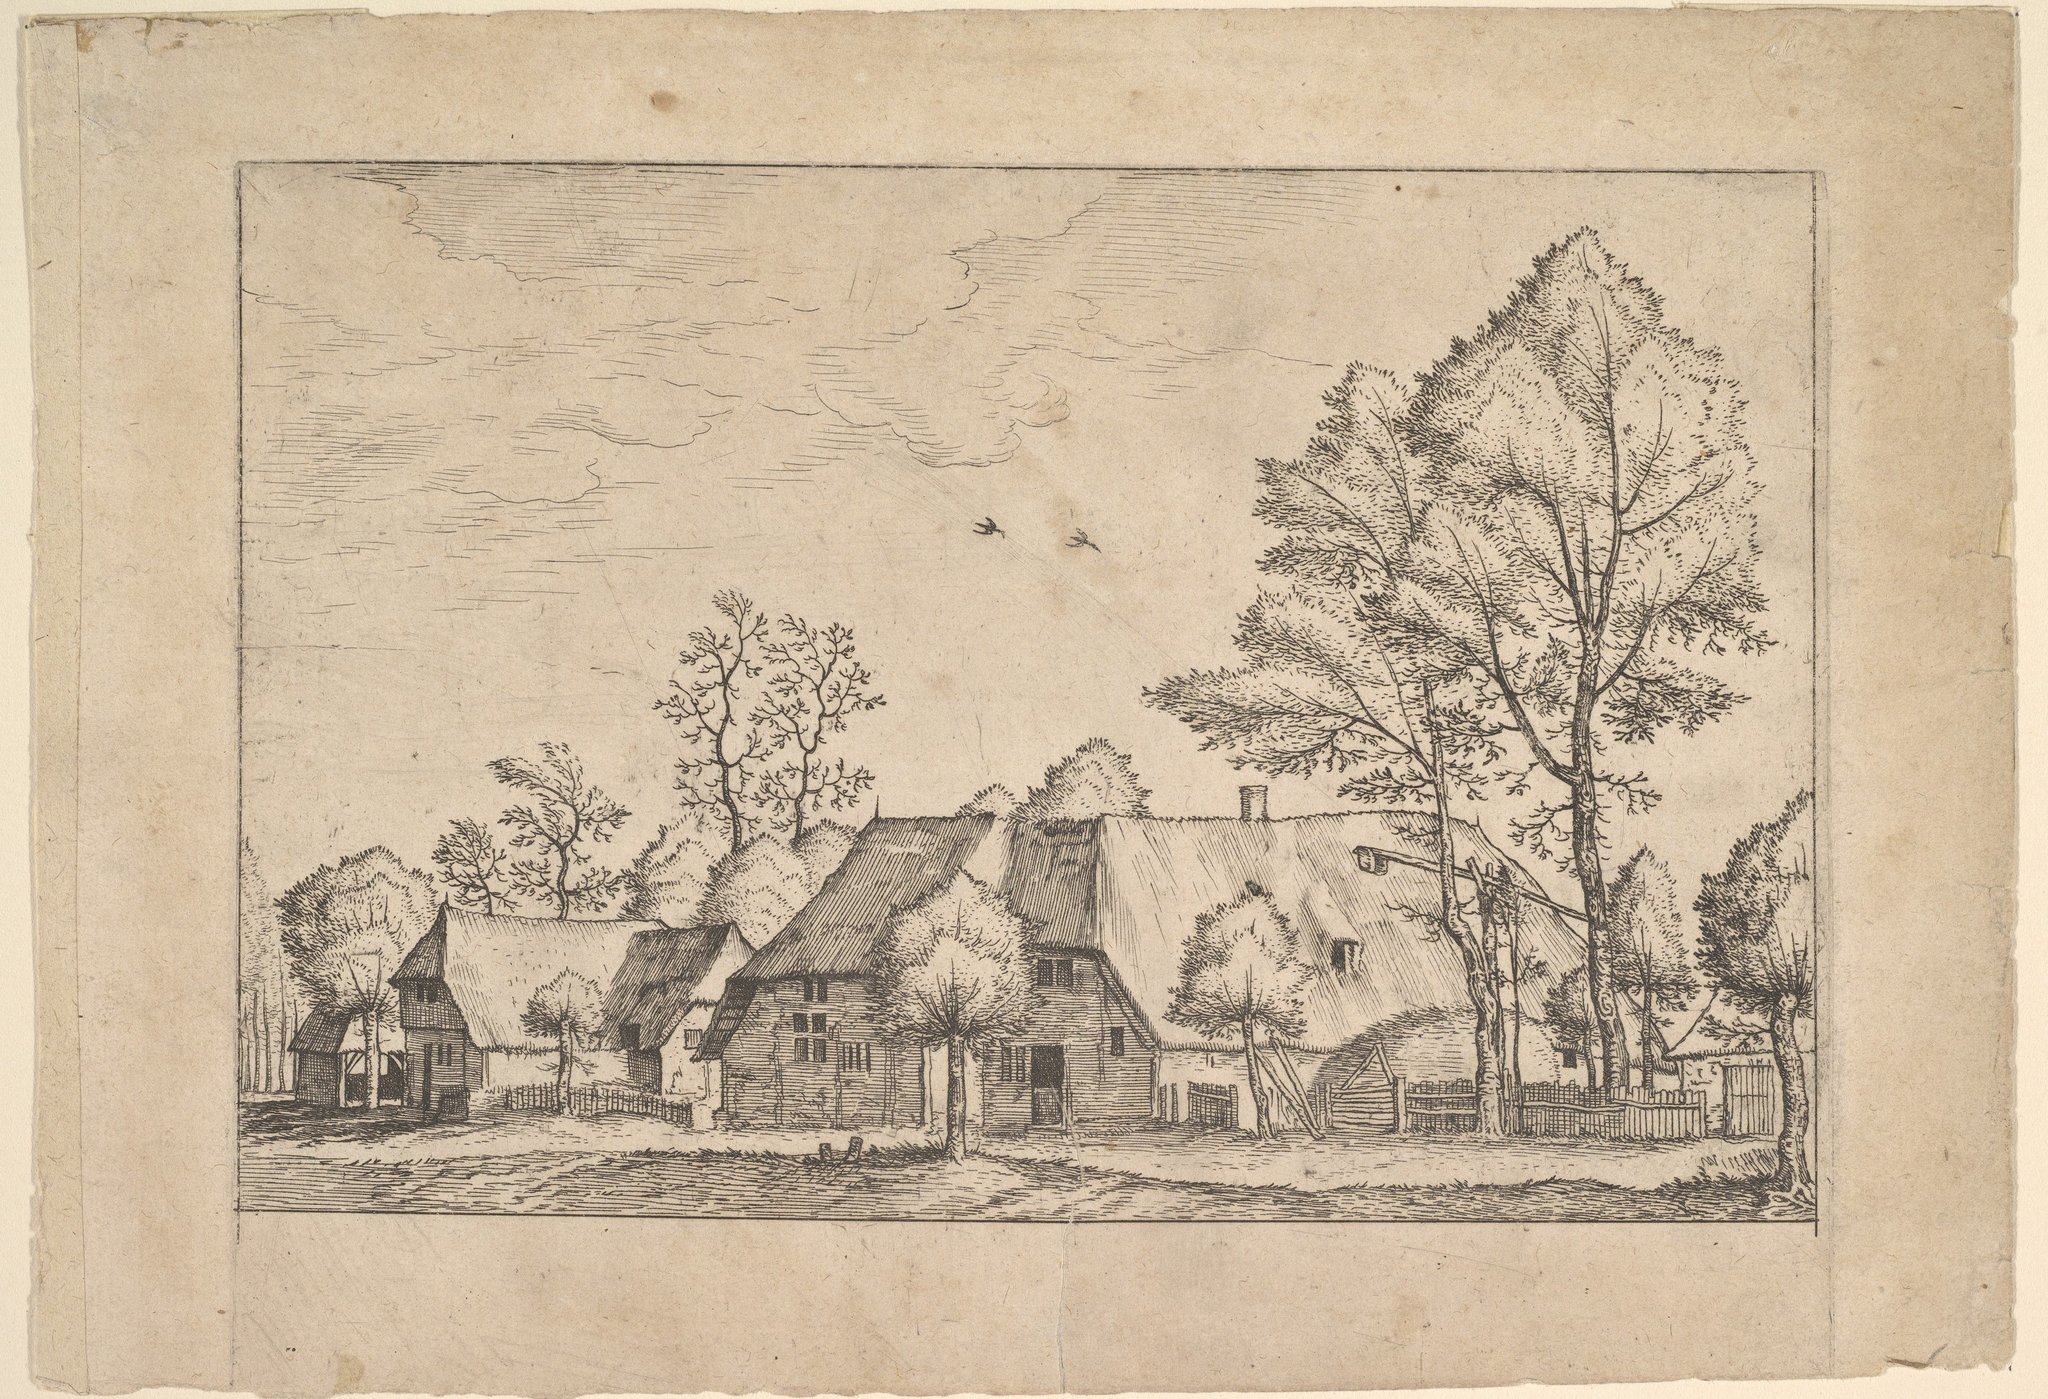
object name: print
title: Large Farm with Draw Well from Praediorum villarum et rusticarum casularum icones elenoantissimae ad vivum in apre deformatae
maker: johannes van doetecum i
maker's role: artist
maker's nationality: netherlandish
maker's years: 1528-1605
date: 1559-1561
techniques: etching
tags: houses,farms,trees